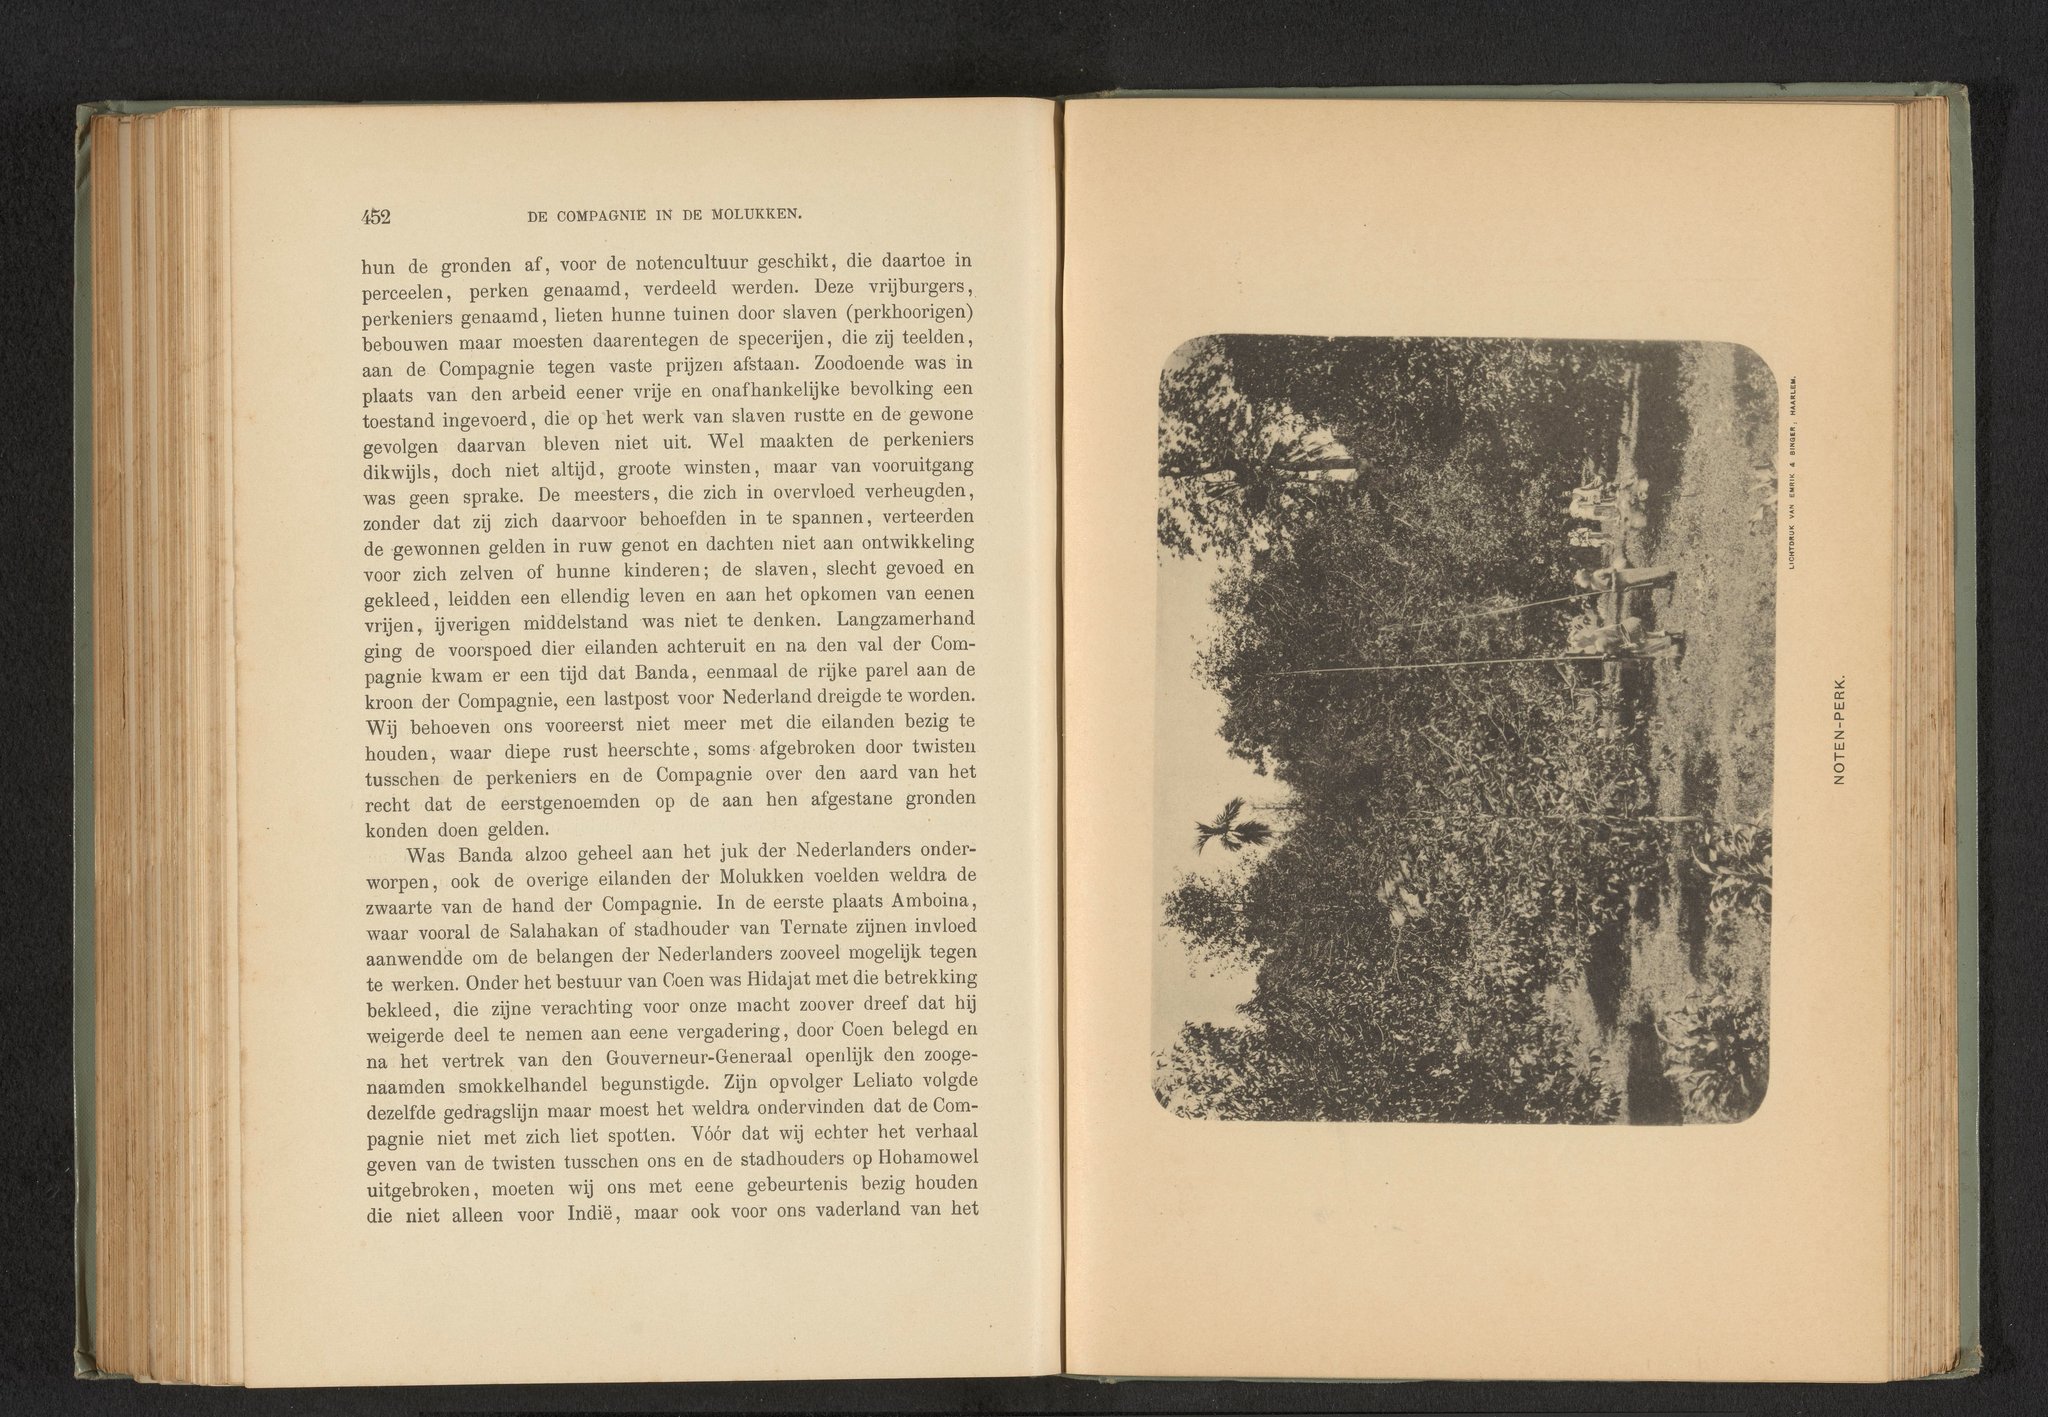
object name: page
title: Gezicht op vermoedelijk een notenplantage op de Molukken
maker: Anonymous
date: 1883-1894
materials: paper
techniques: photograph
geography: moluccas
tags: plantation